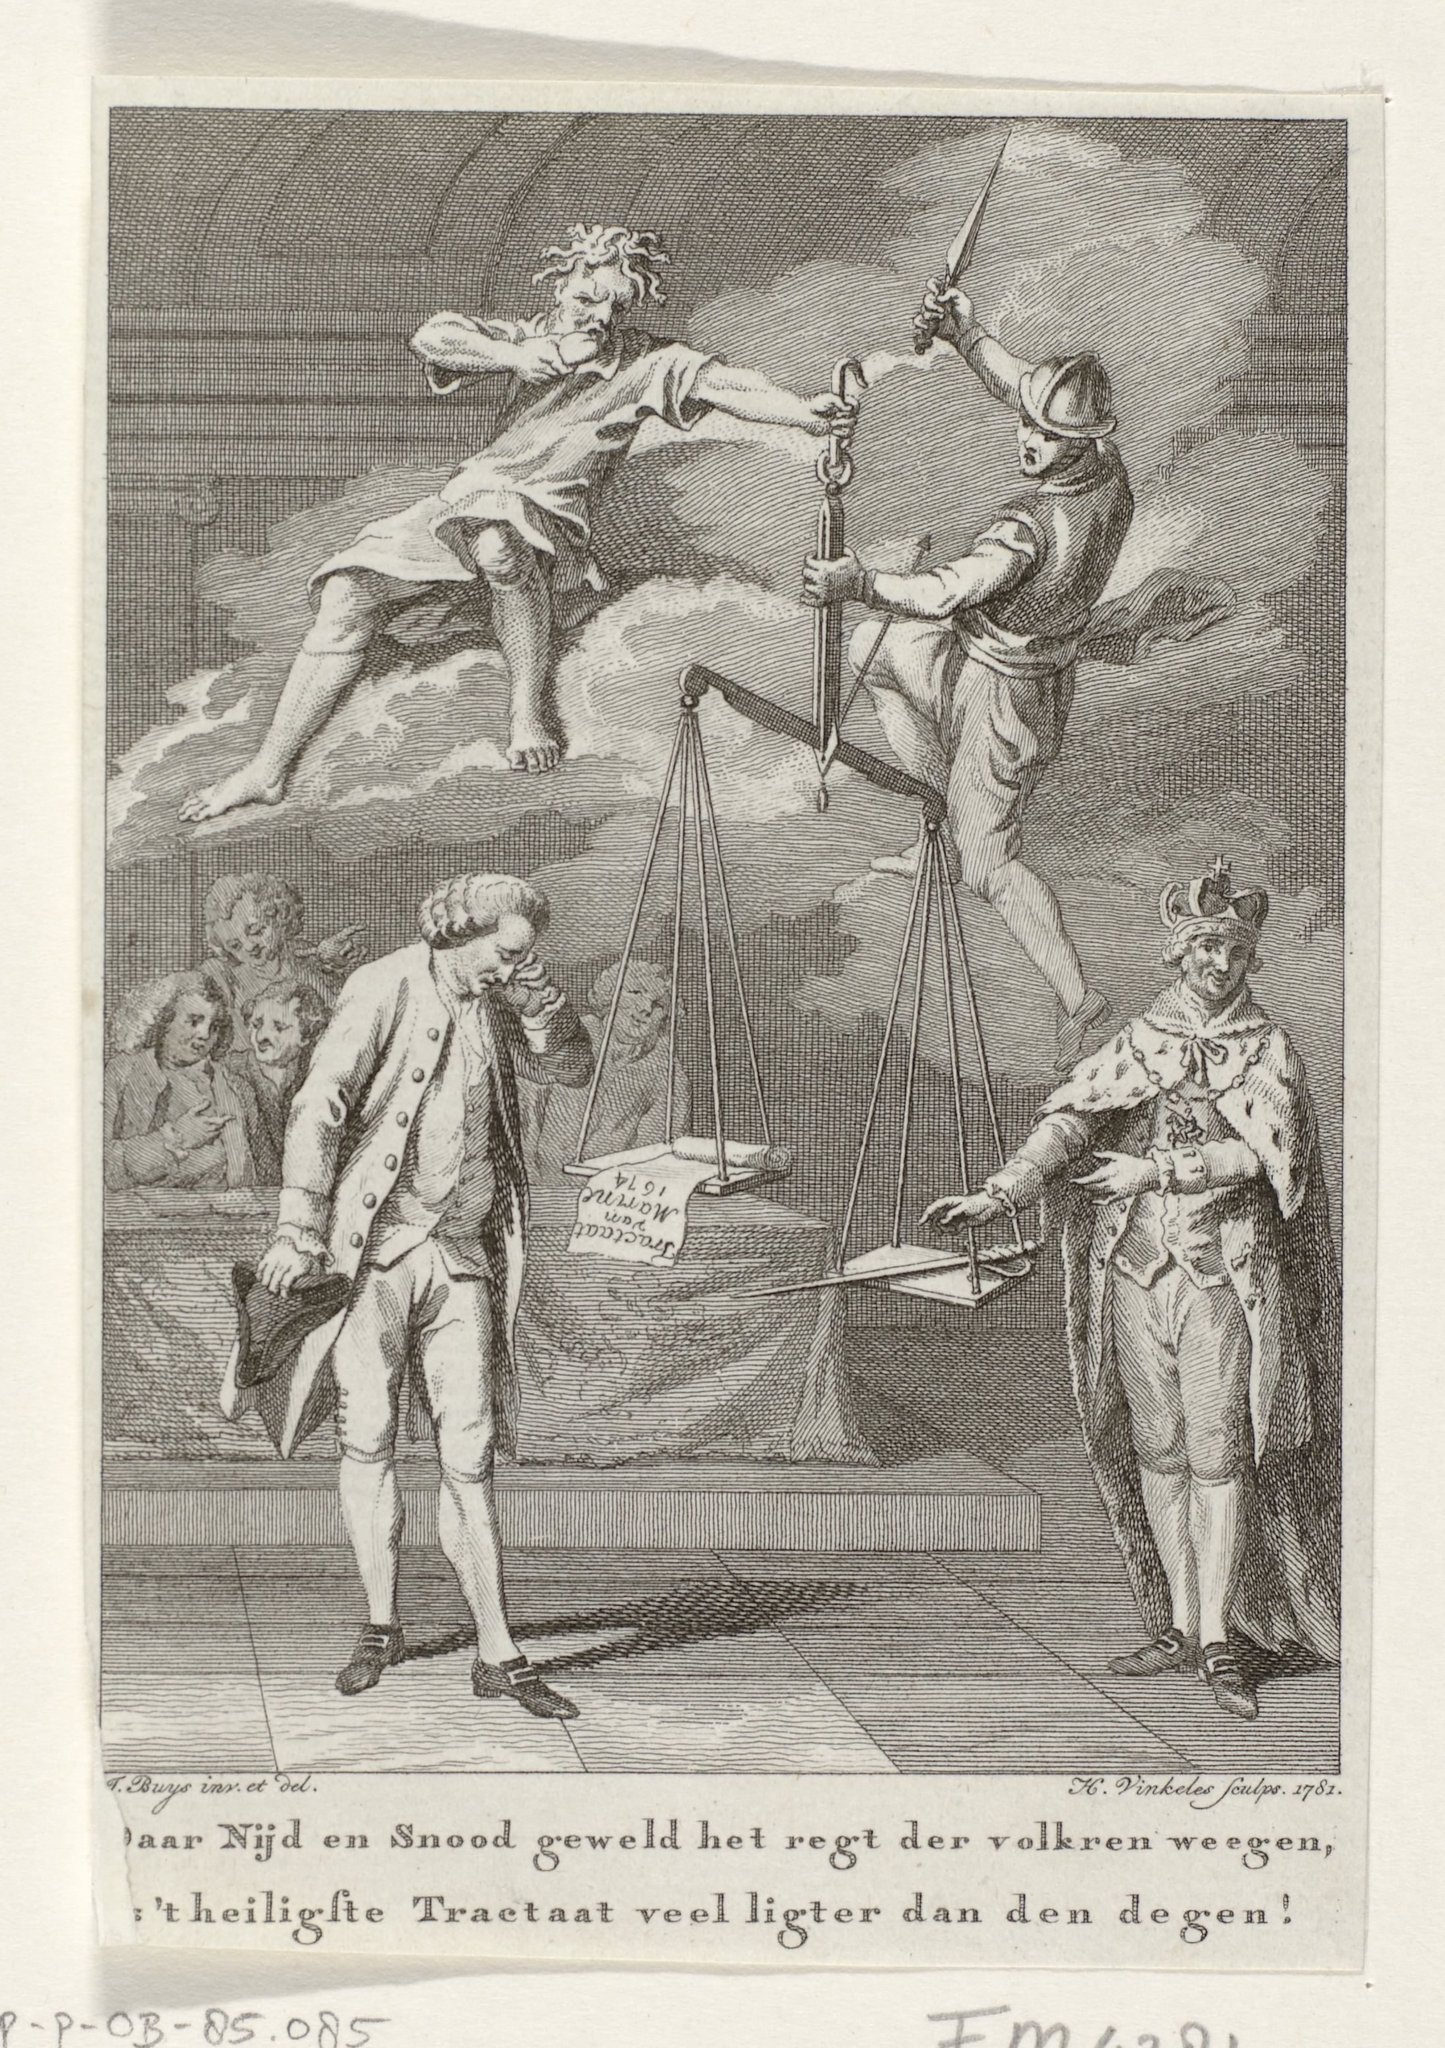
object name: cartoon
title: Allegorie op het verbreken door de Engelsen van het Tractaat van Marine uit 1670, ca. 1780-1781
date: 1781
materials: paper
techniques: engraving, etching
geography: northern netherlands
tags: london, george iii (koning van het verenigd koninkrijk), scales, fourth anglo-dutch war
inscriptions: collector's mark: Lugt 2228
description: Allegorie op het verbreken door de Engelsen van het Tractaat van Marine uit 1670, ca. 1780-1781. De Engelse koning George III ligt zijn zwaard op de weegschaal met het tractaat. Met hierbij een treurende Nederlander. In de lucht Geweld en Afgunst. In het onderschrift een tweeregelig vers.